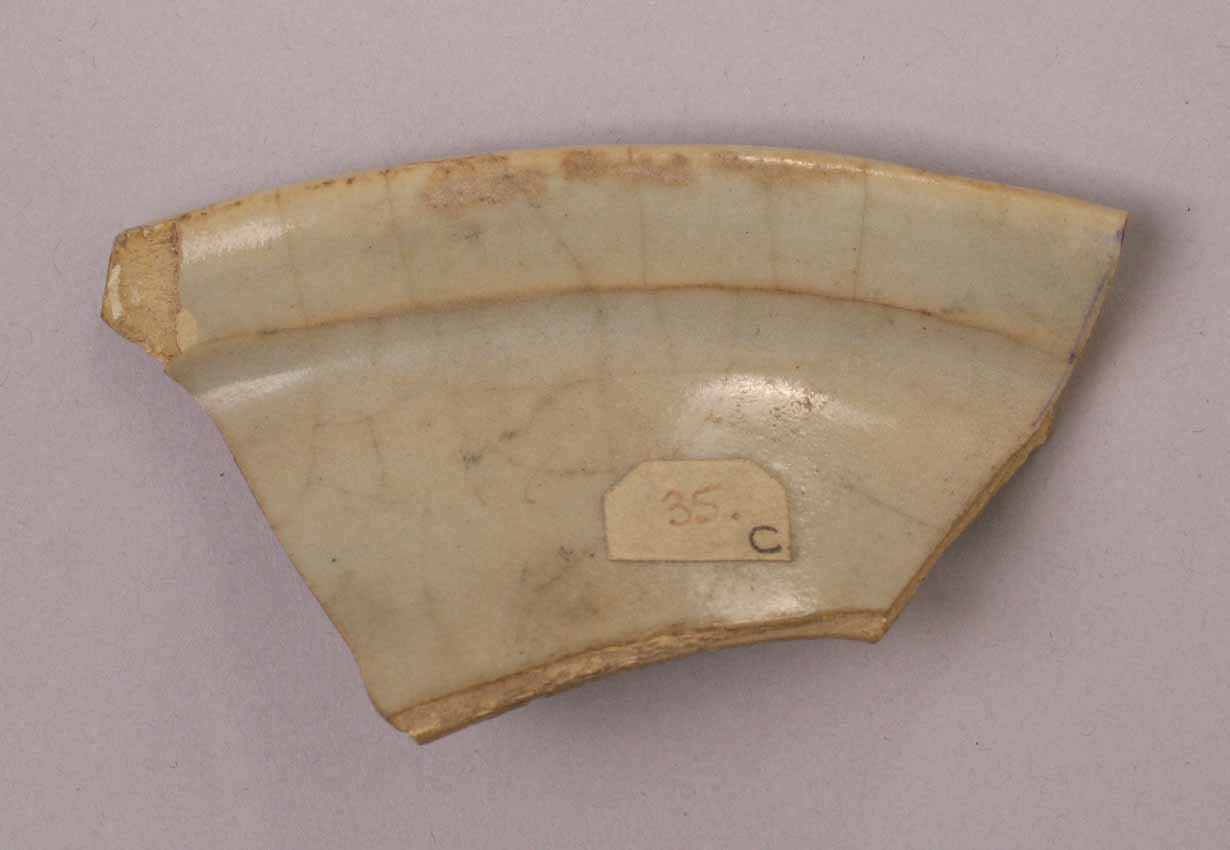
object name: fragment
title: Fragments of Ceramics with Opacified Glaze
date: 801-900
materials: earthenware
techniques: glazing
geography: iraq